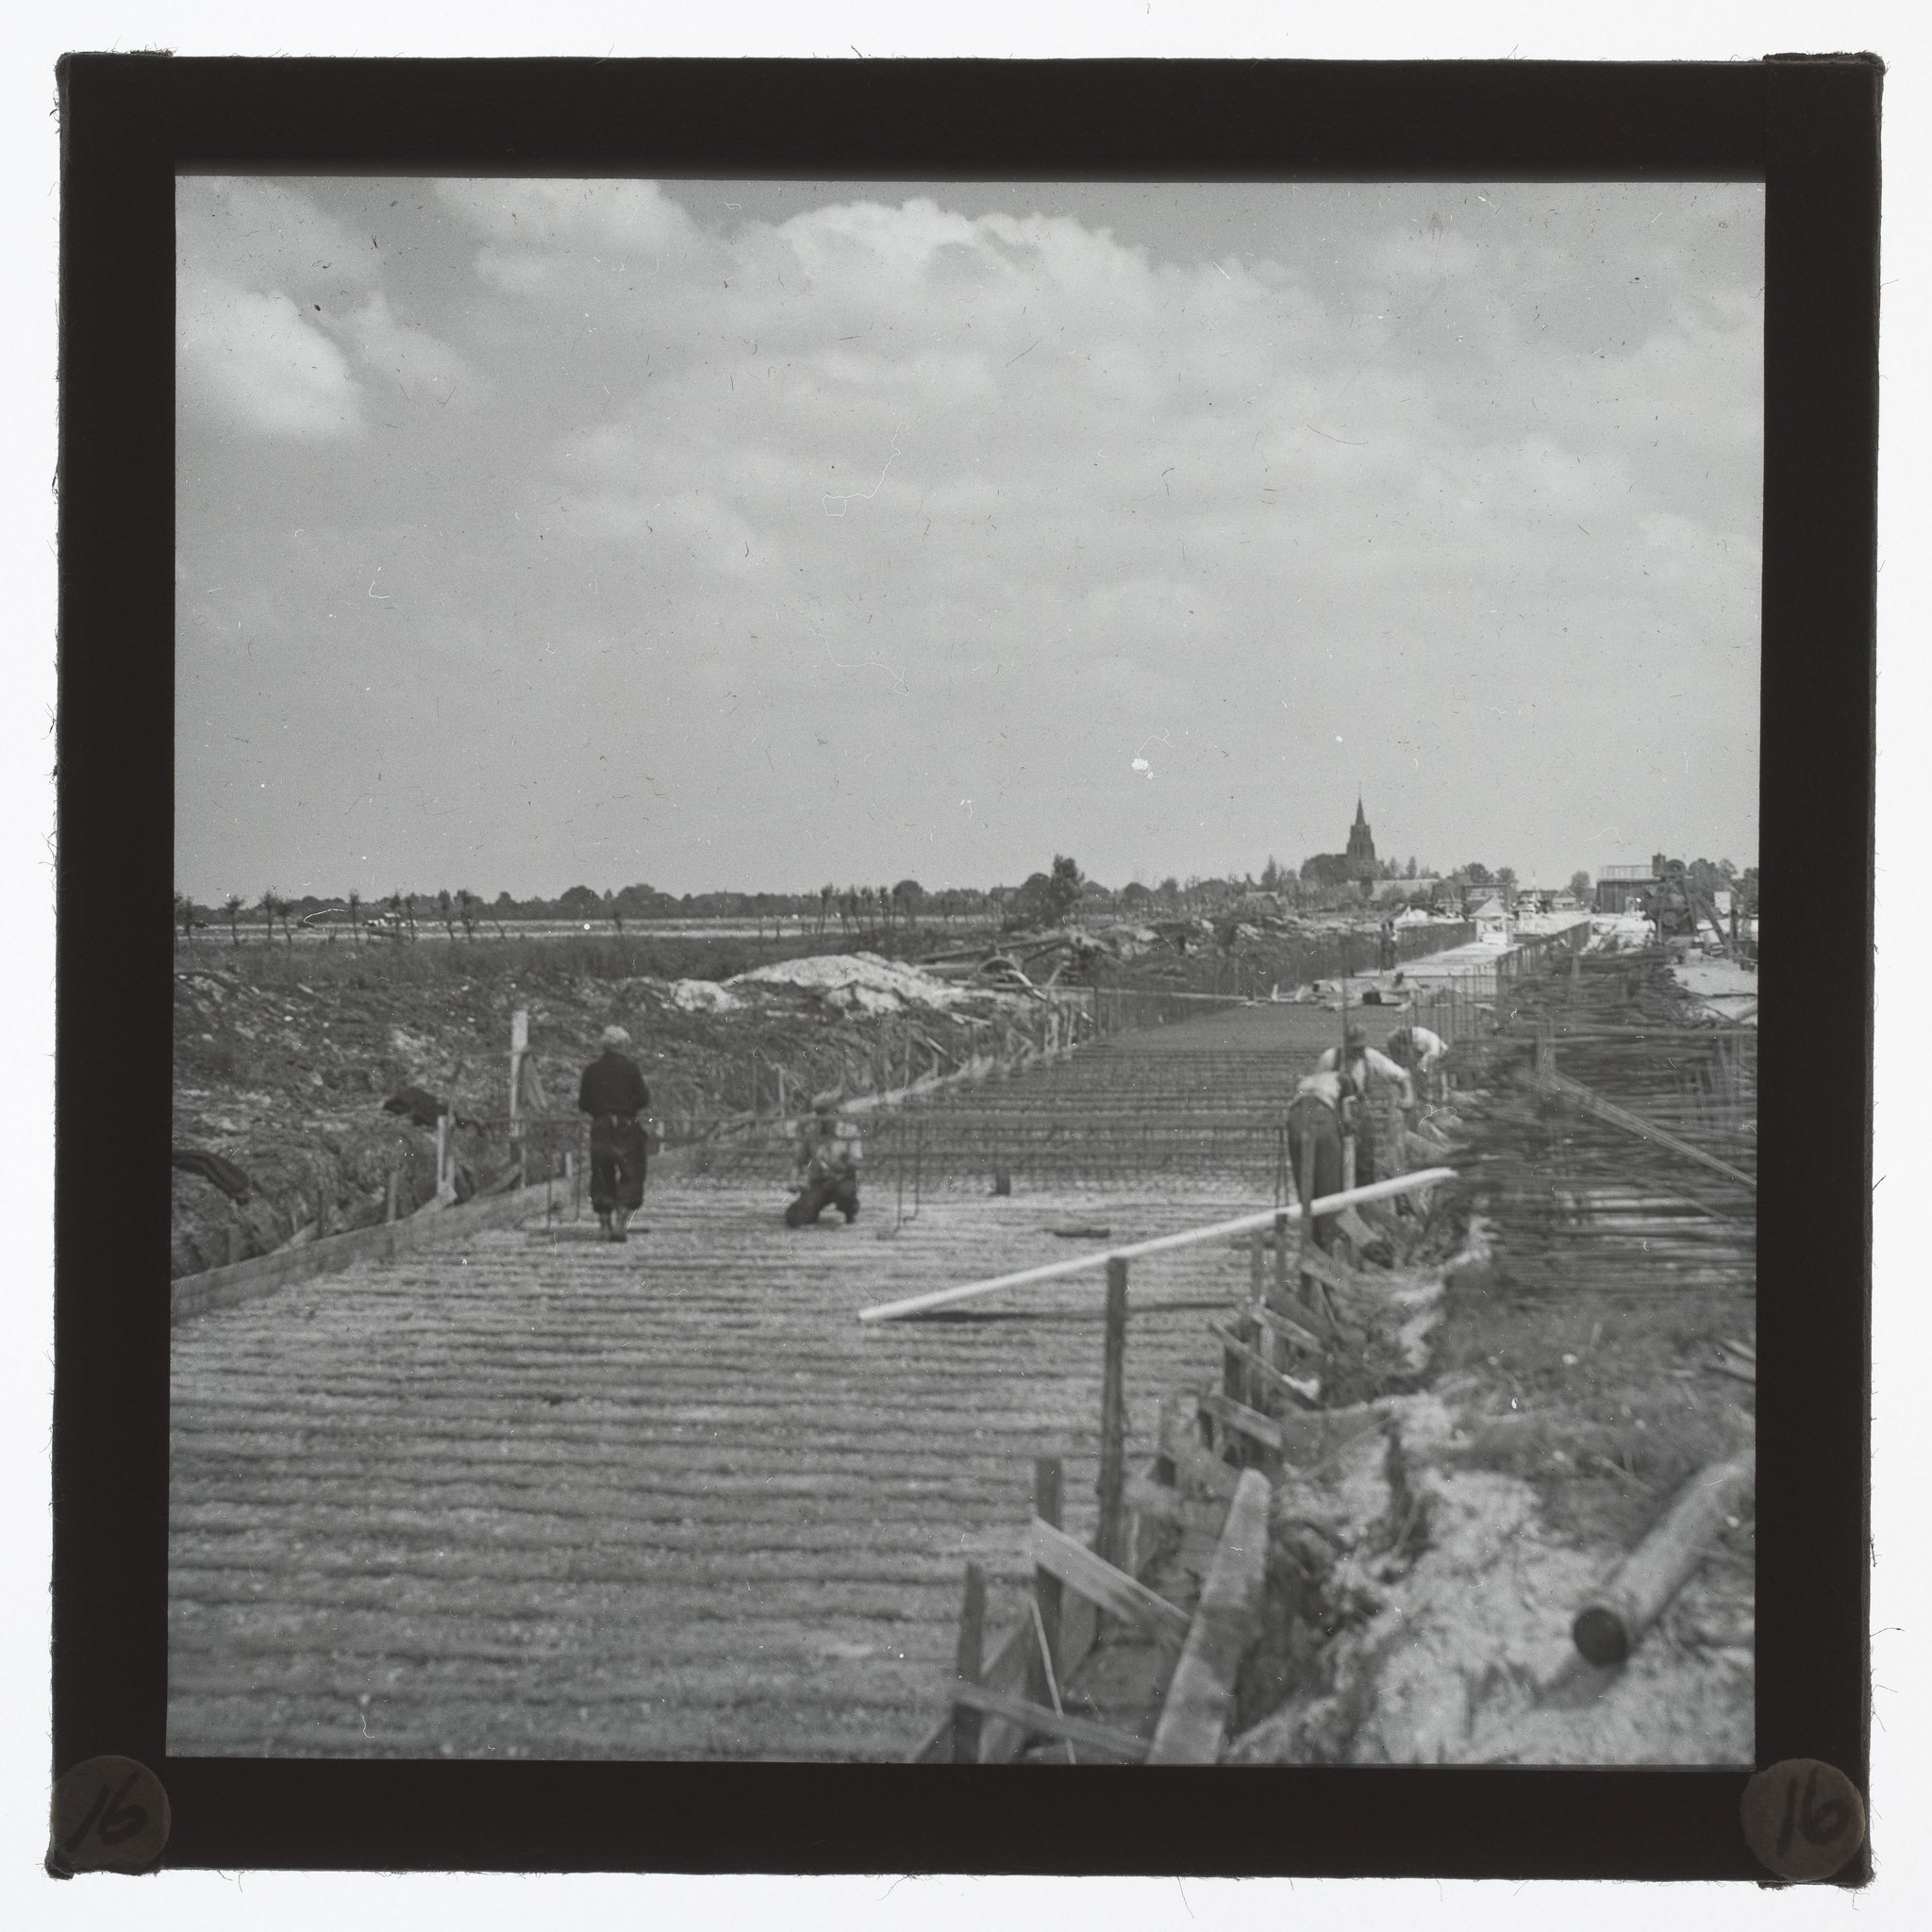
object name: lantern slide photographic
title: Gezicht op een bouwplaats, Zuid-Holland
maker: Anonymous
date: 1956-1960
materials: glass, paper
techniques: gelatin silver transparency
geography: south holland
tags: building-site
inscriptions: number: ‘16’